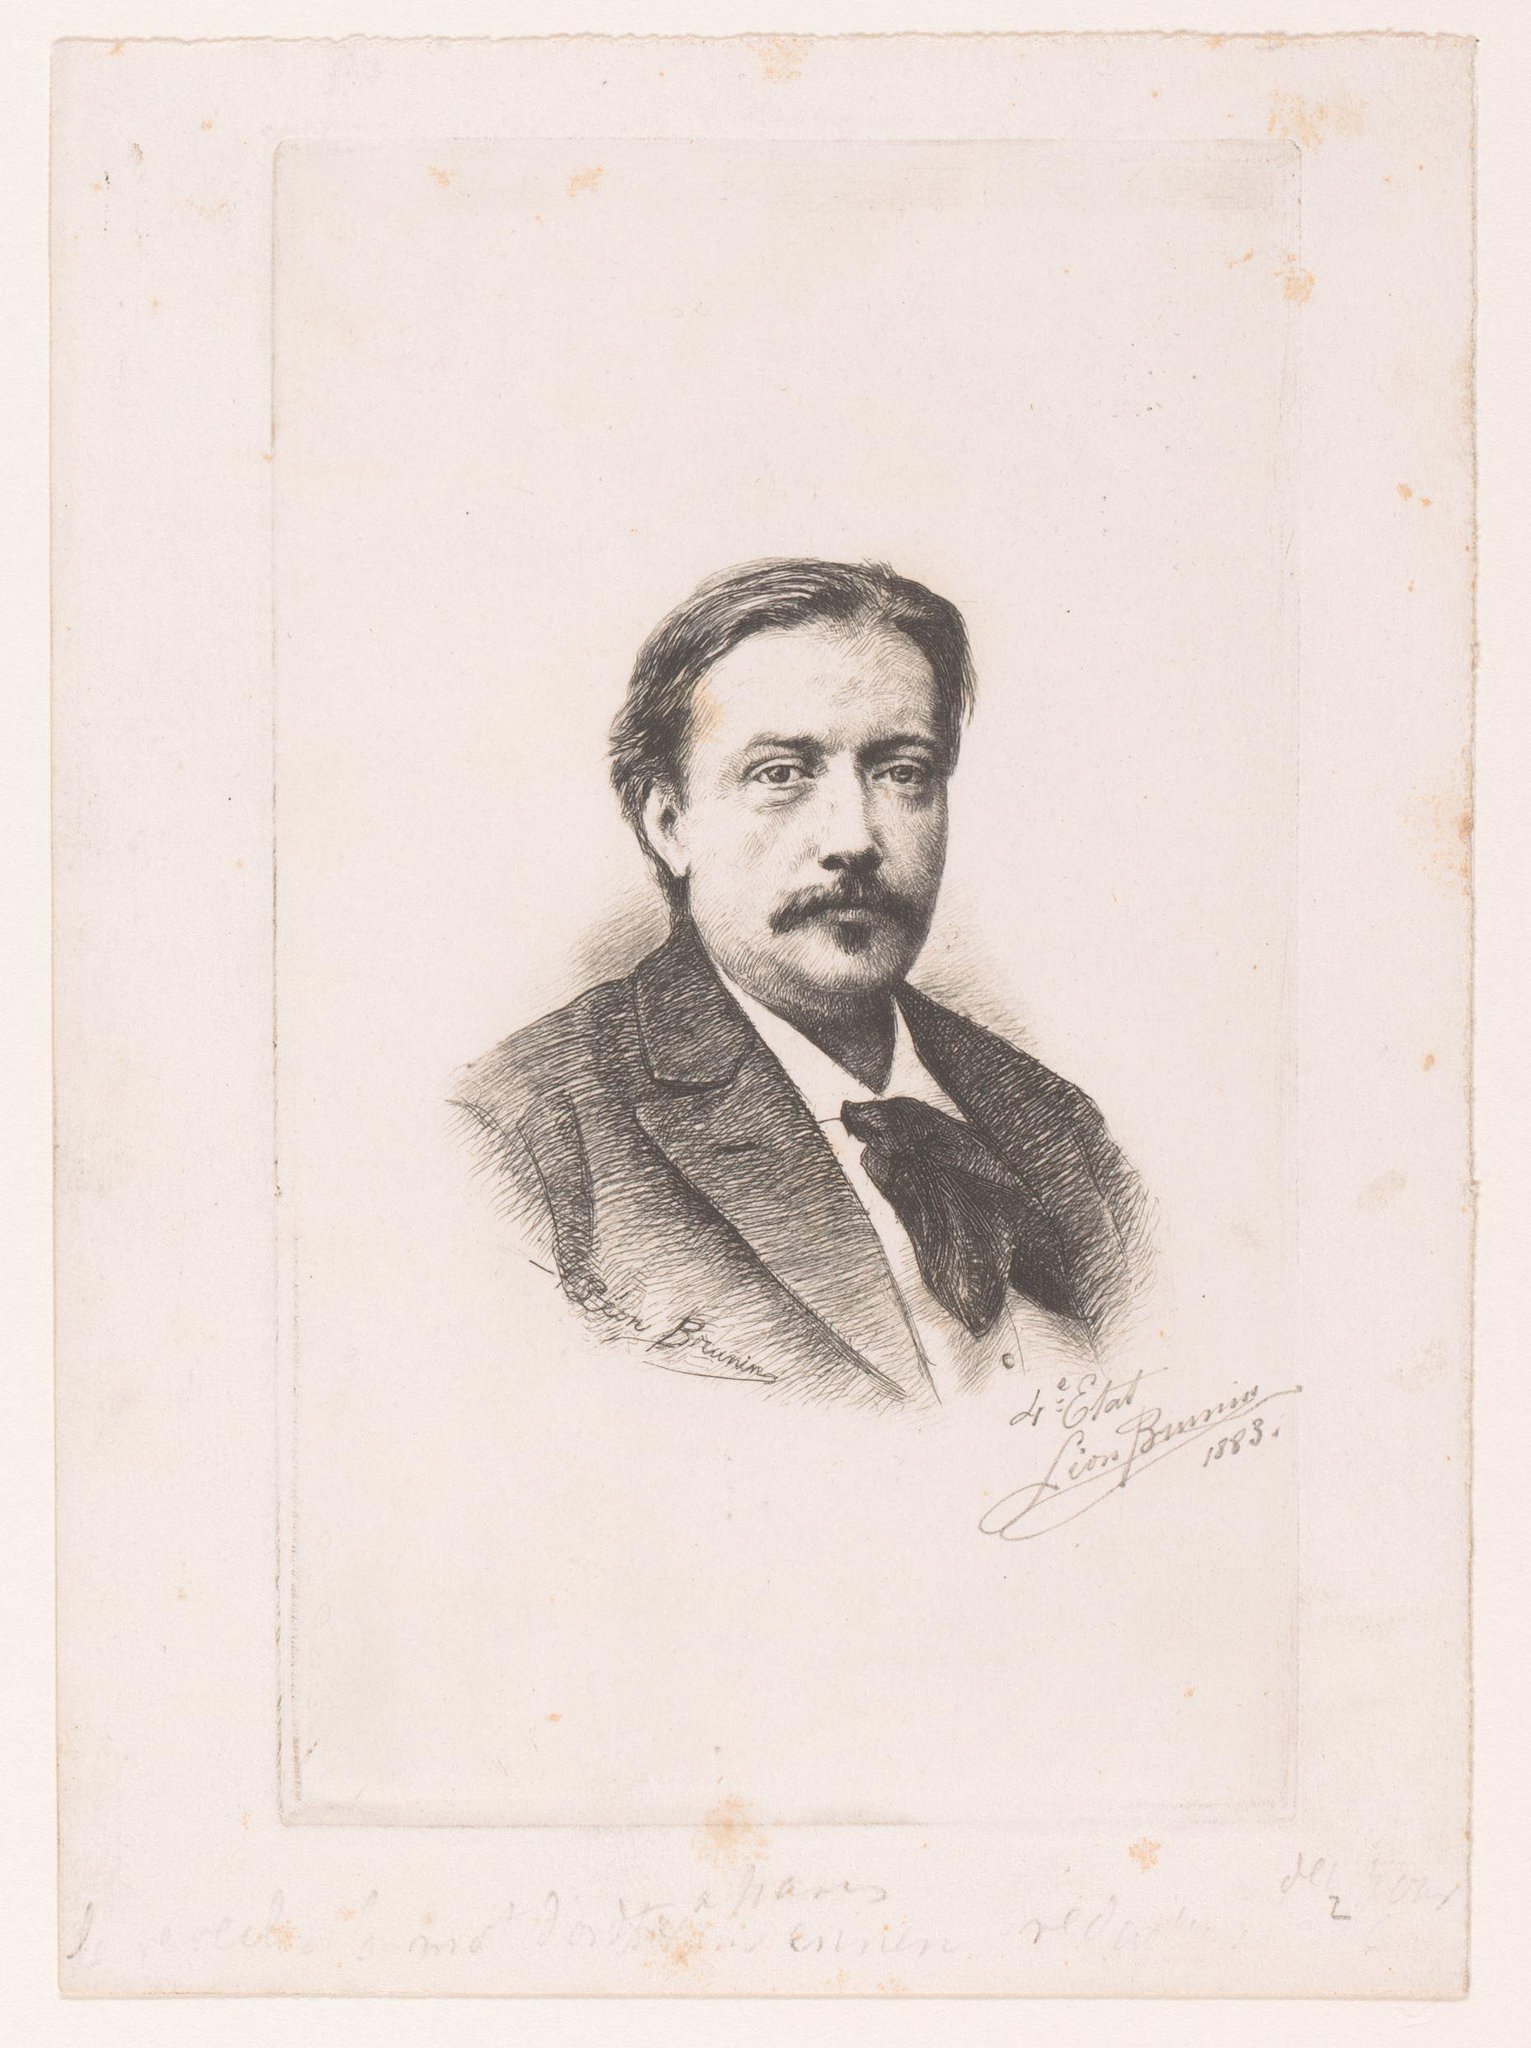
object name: print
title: Portret van Francis Enne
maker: léon brunin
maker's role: print maker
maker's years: 1861-1949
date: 1883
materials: paper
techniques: etching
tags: journalist, reporter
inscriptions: annotation: ‘4e Etat’, collector's mark: Lugt 2228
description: Een latere staat van deze prent is gebruikt in: Enne, Francis. D'Après nature (deuxième série). Brussel: Henry Kistemaeckers, 1883, tegenover titelpagina.